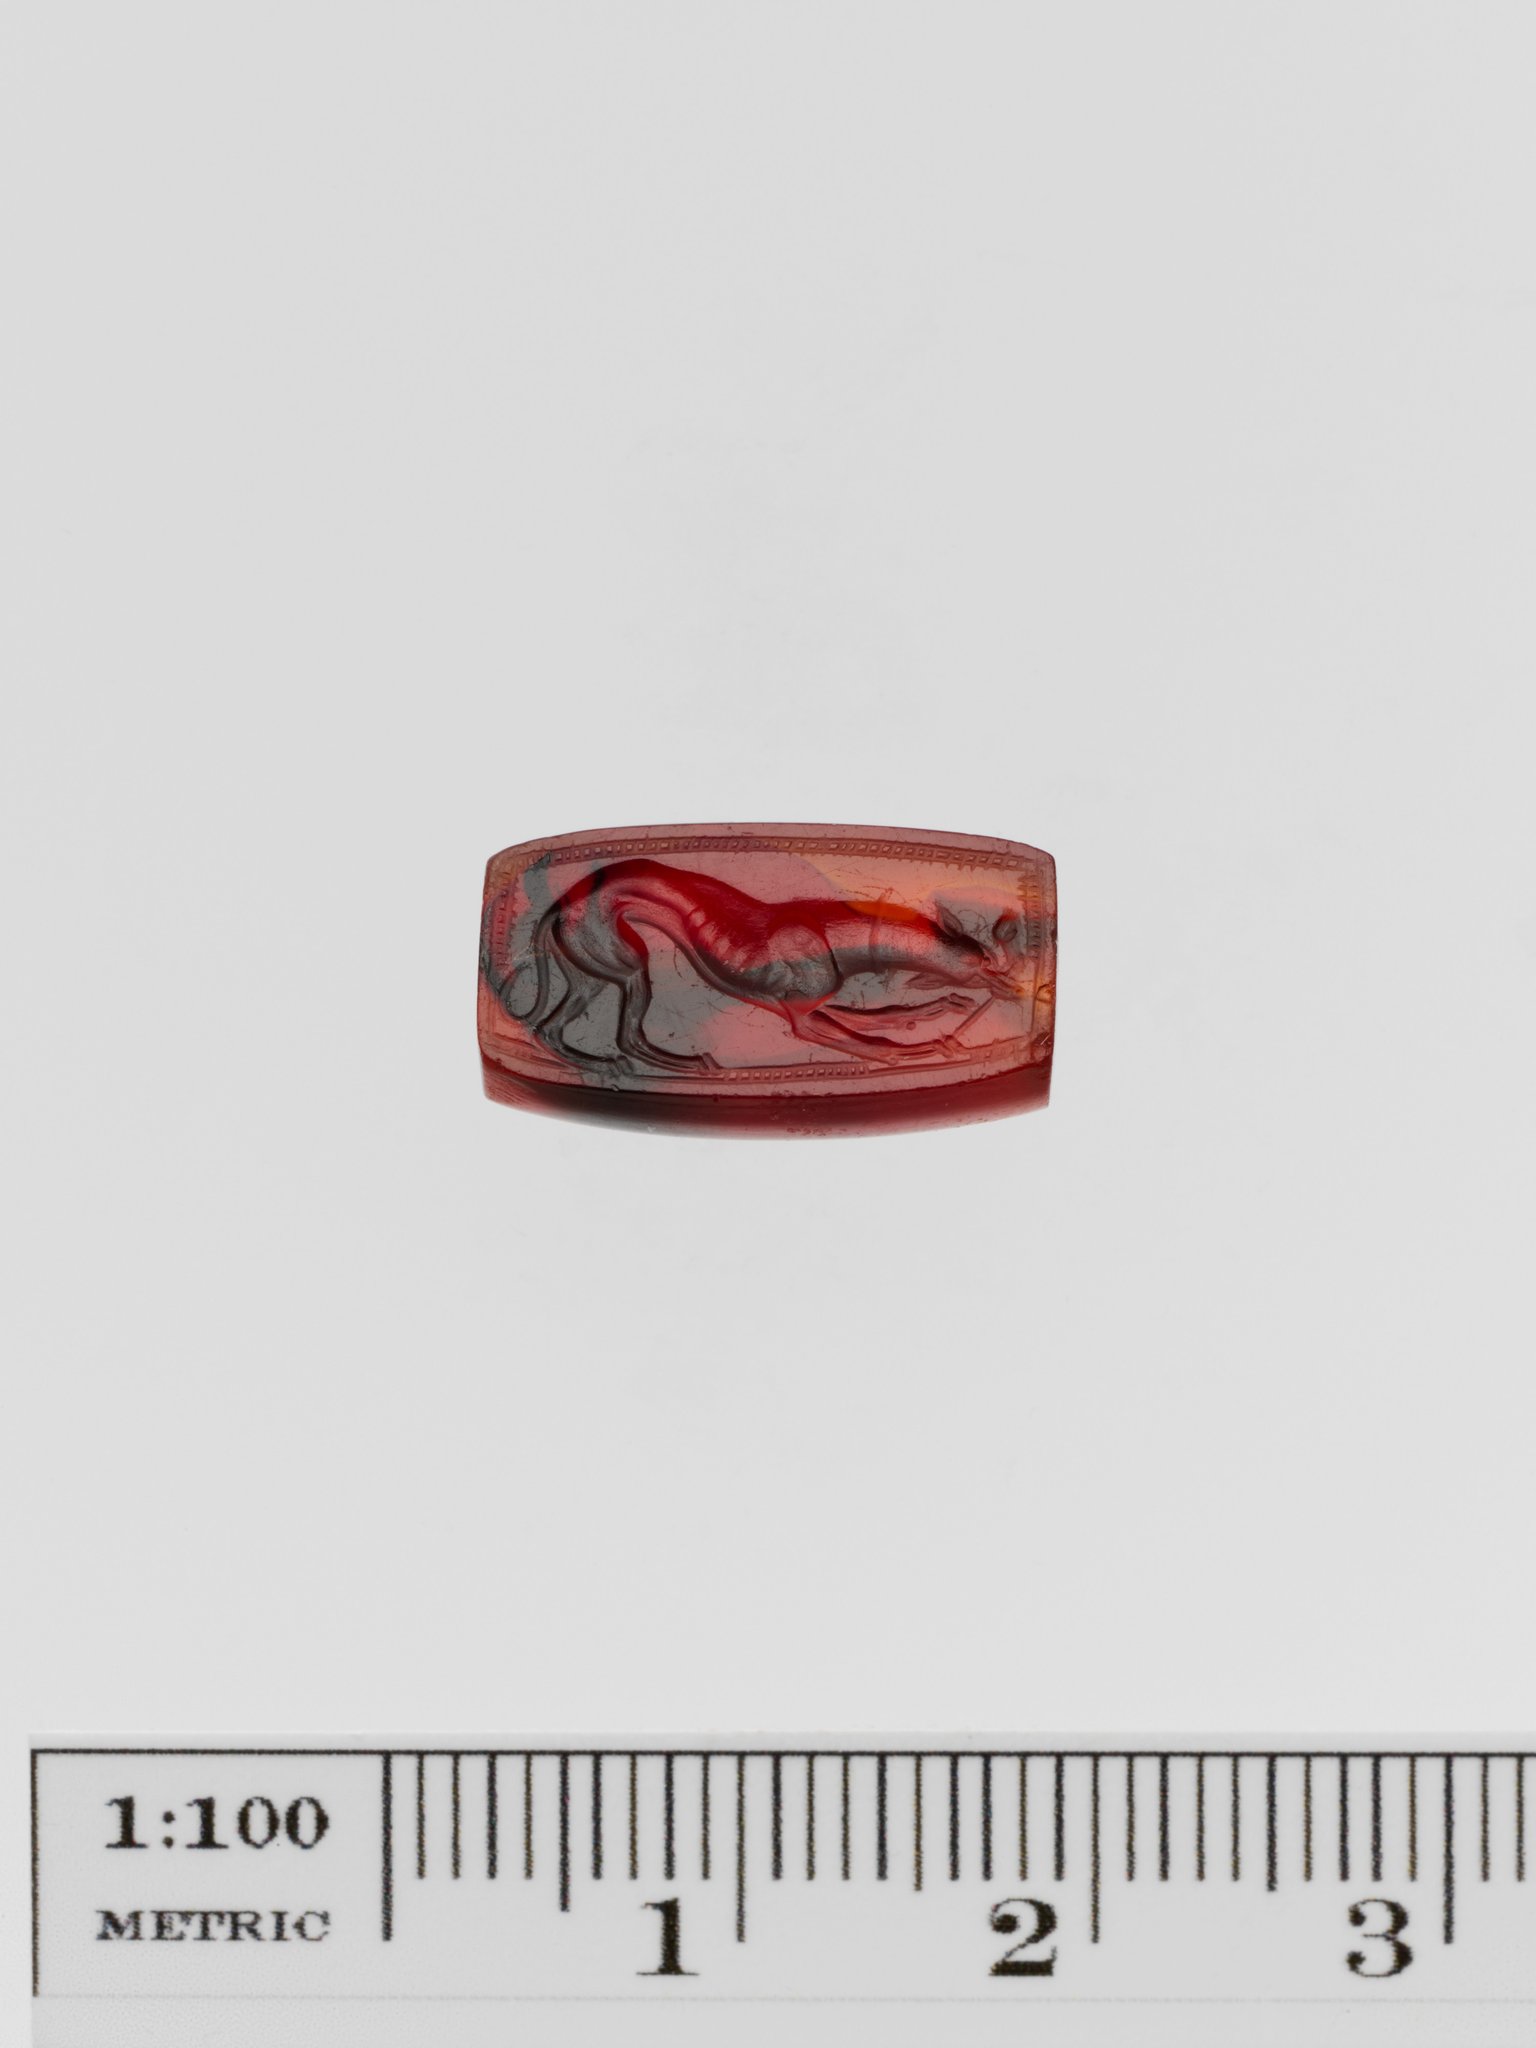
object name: intaglio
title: Carnelian half-barrel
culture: greek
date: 450-400 BCE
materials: gemstone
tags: dogs